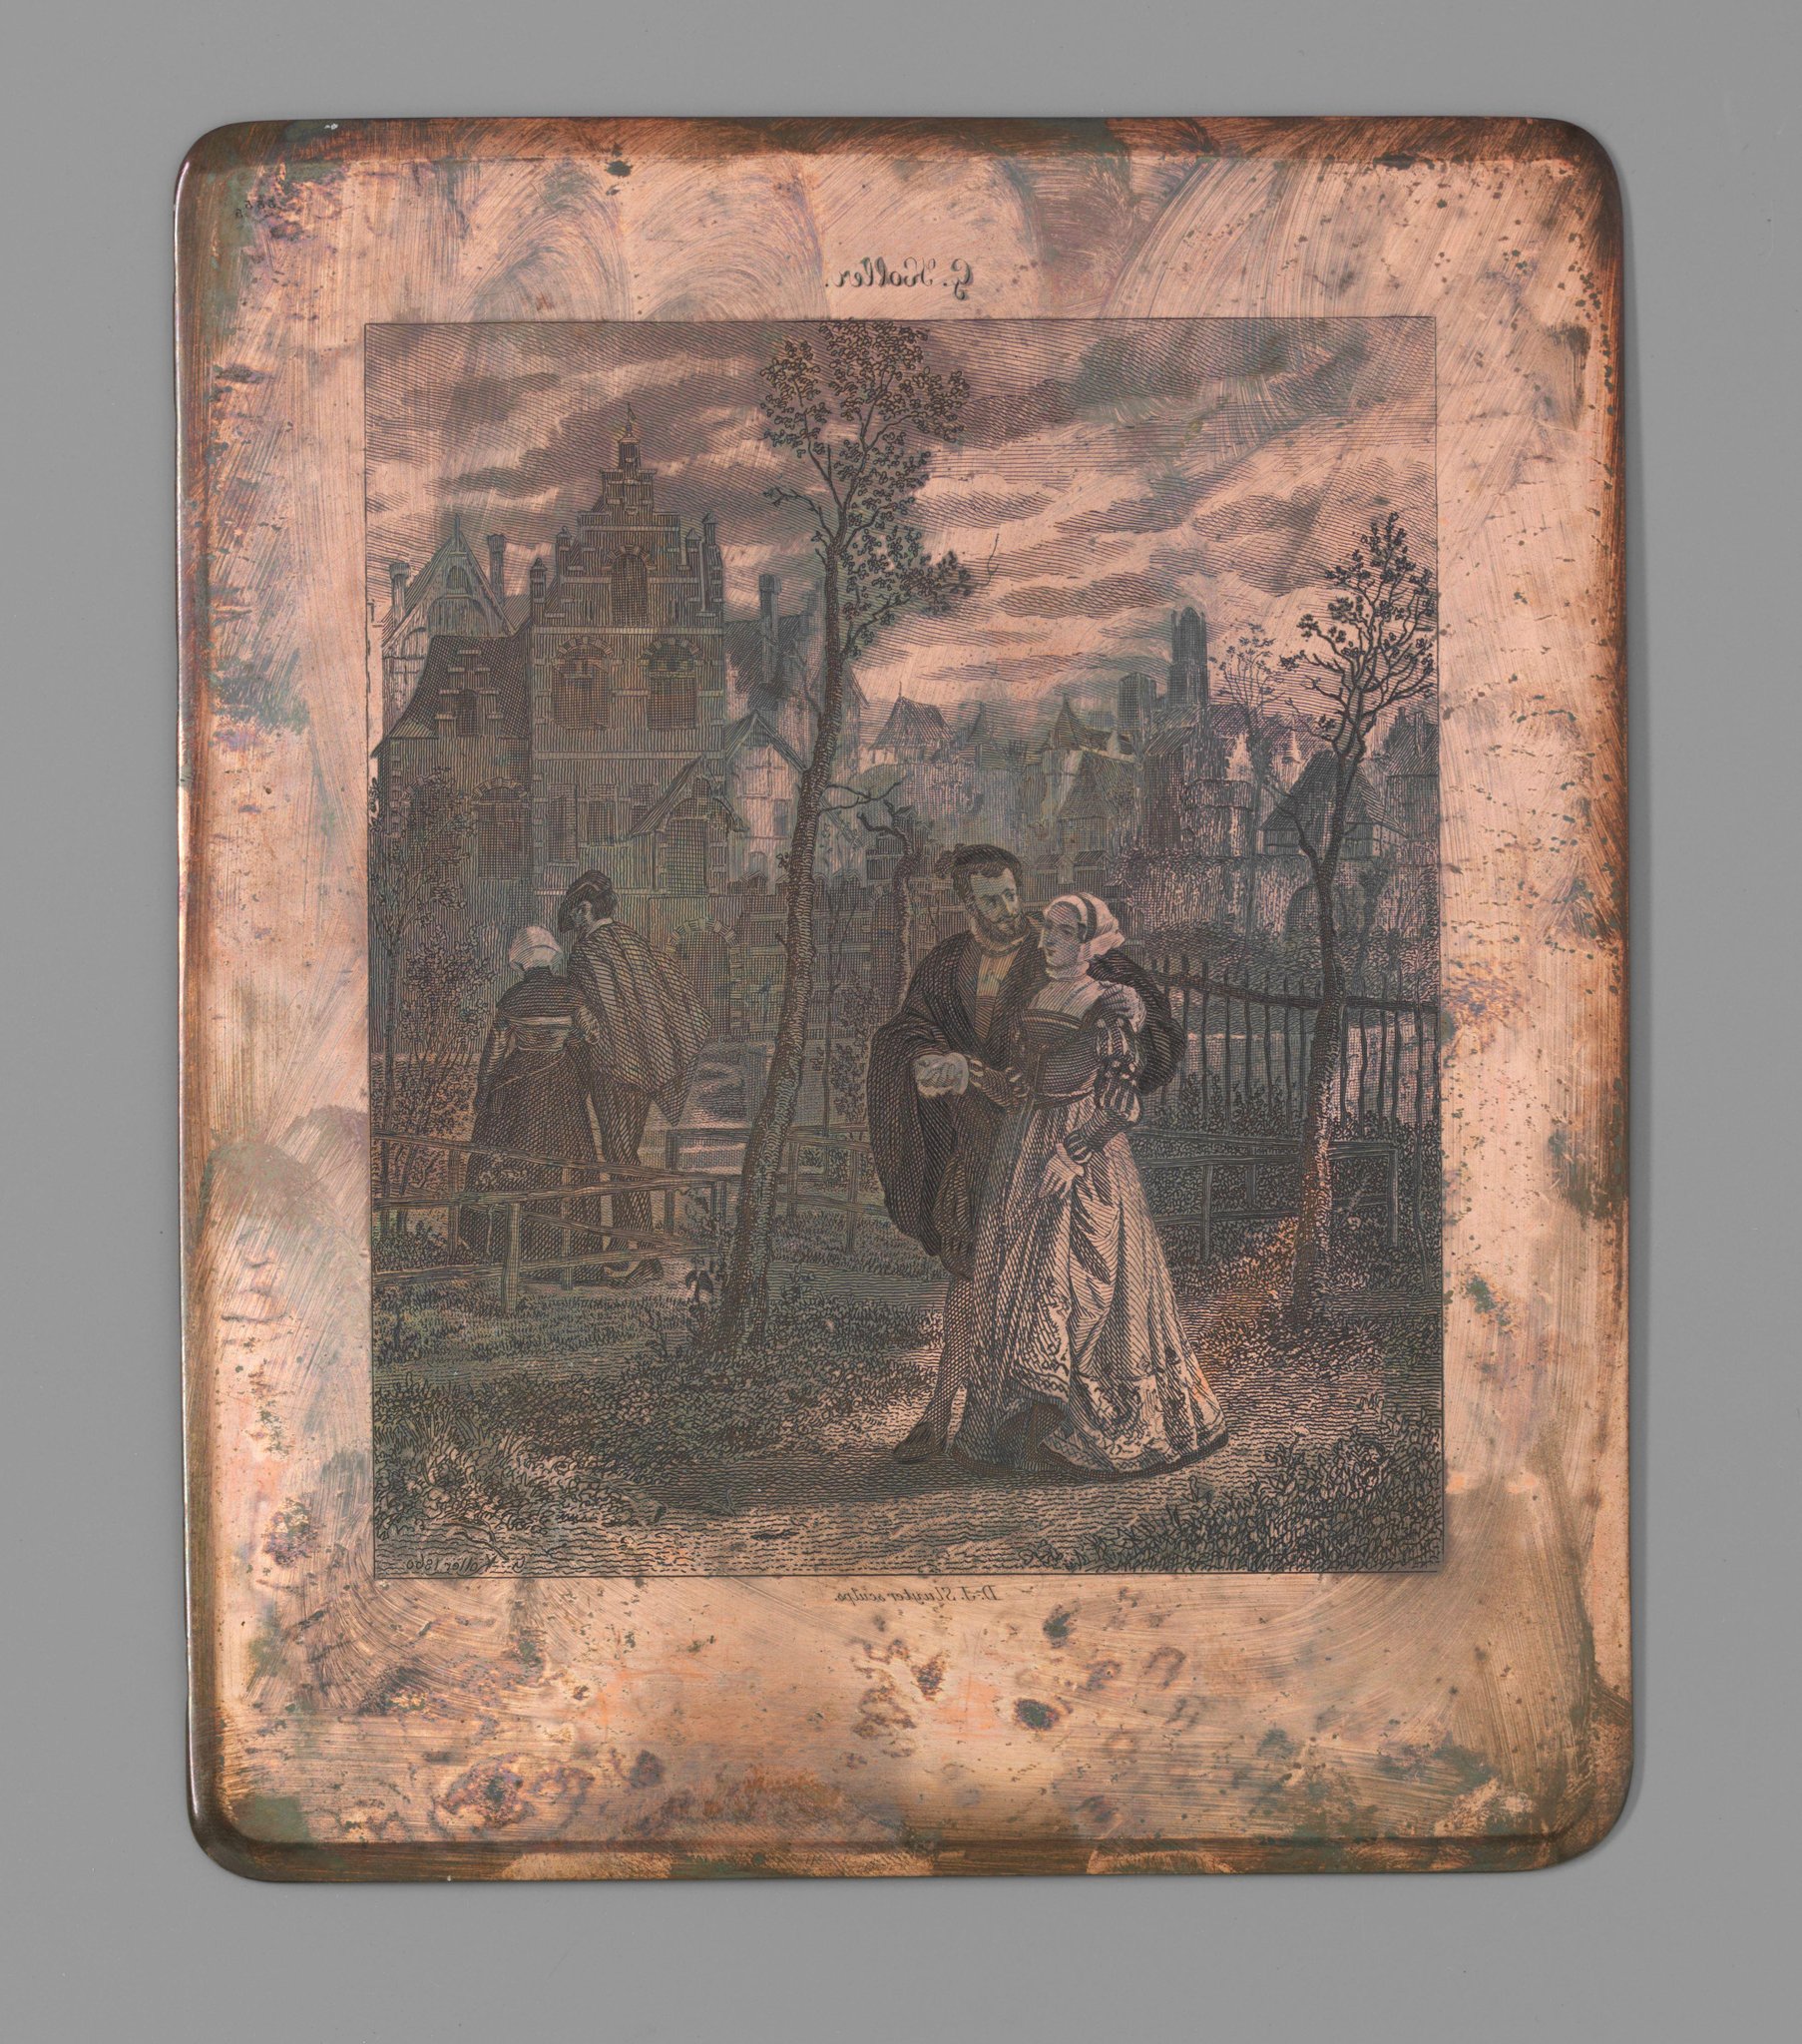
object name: copper plate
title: Twee paren in zestiende-eeuws kostuum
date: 1821-1886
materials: copper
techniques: engraving